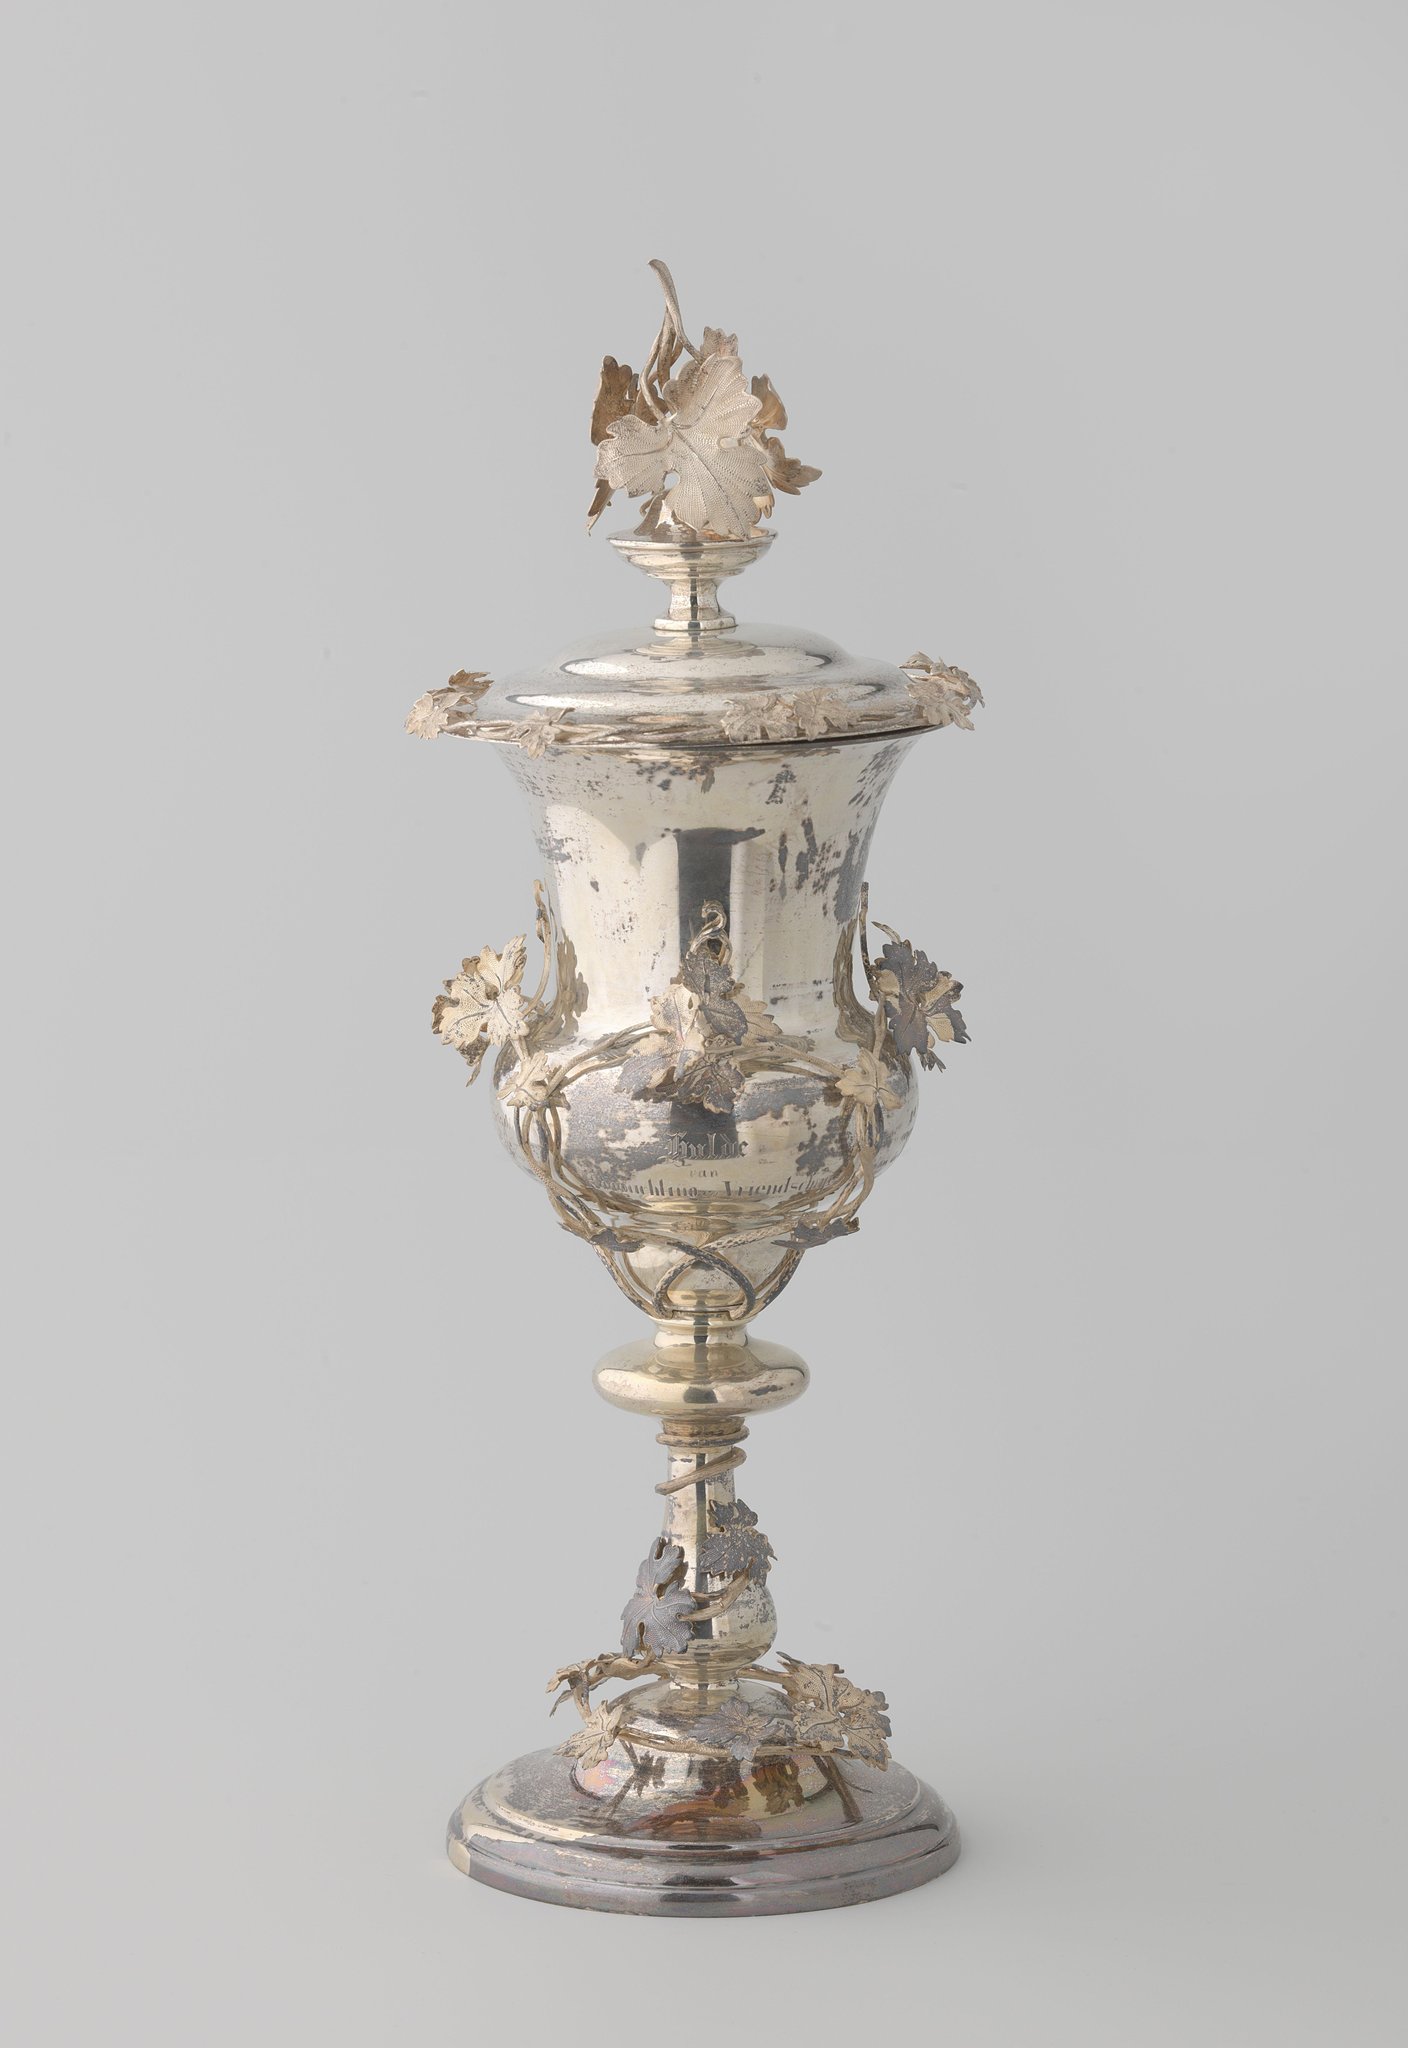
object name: lid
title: Deksel van bokaal.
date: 1869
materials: silver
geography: voorschoten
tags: guillaume groen van prinsterer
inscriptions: mark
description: Bokaal van zilver. De voet rust op een rechtwandige basis. De balustervormige stam gaat vloeiend over in de platte nodus en de cuppa. De cuppa loopt breed uit en heeft een gewelfde deksel. De bokaal is versierd met wijnranken en gegraveerde tekst.